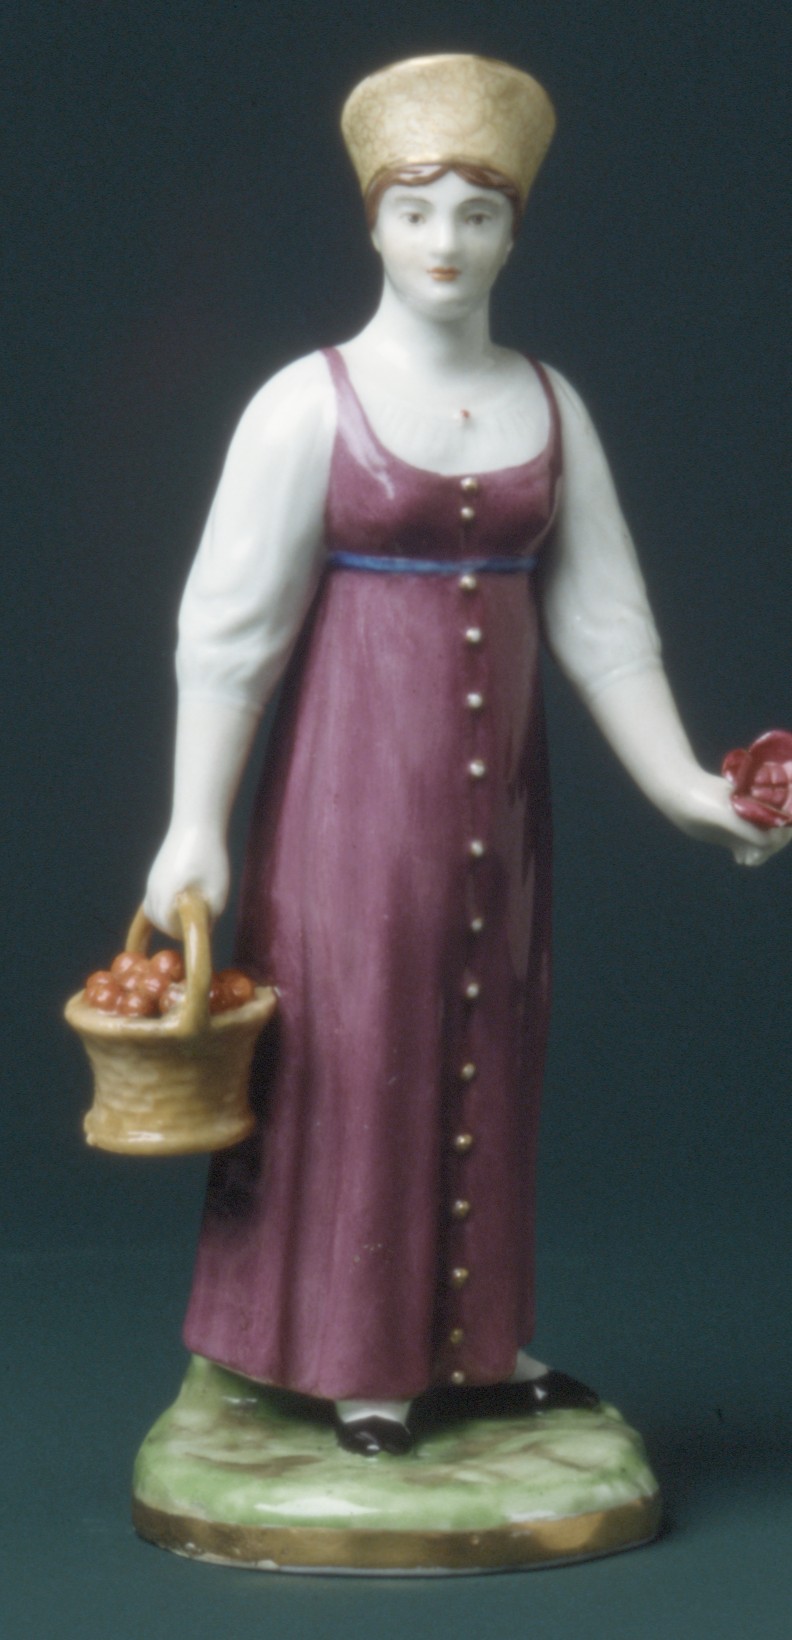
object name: figure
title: Woman with a Fruit Basket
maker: gardner manufactory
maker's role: manufactory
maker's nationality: russian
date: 1820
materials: hard paste porcelain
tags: fruit,women